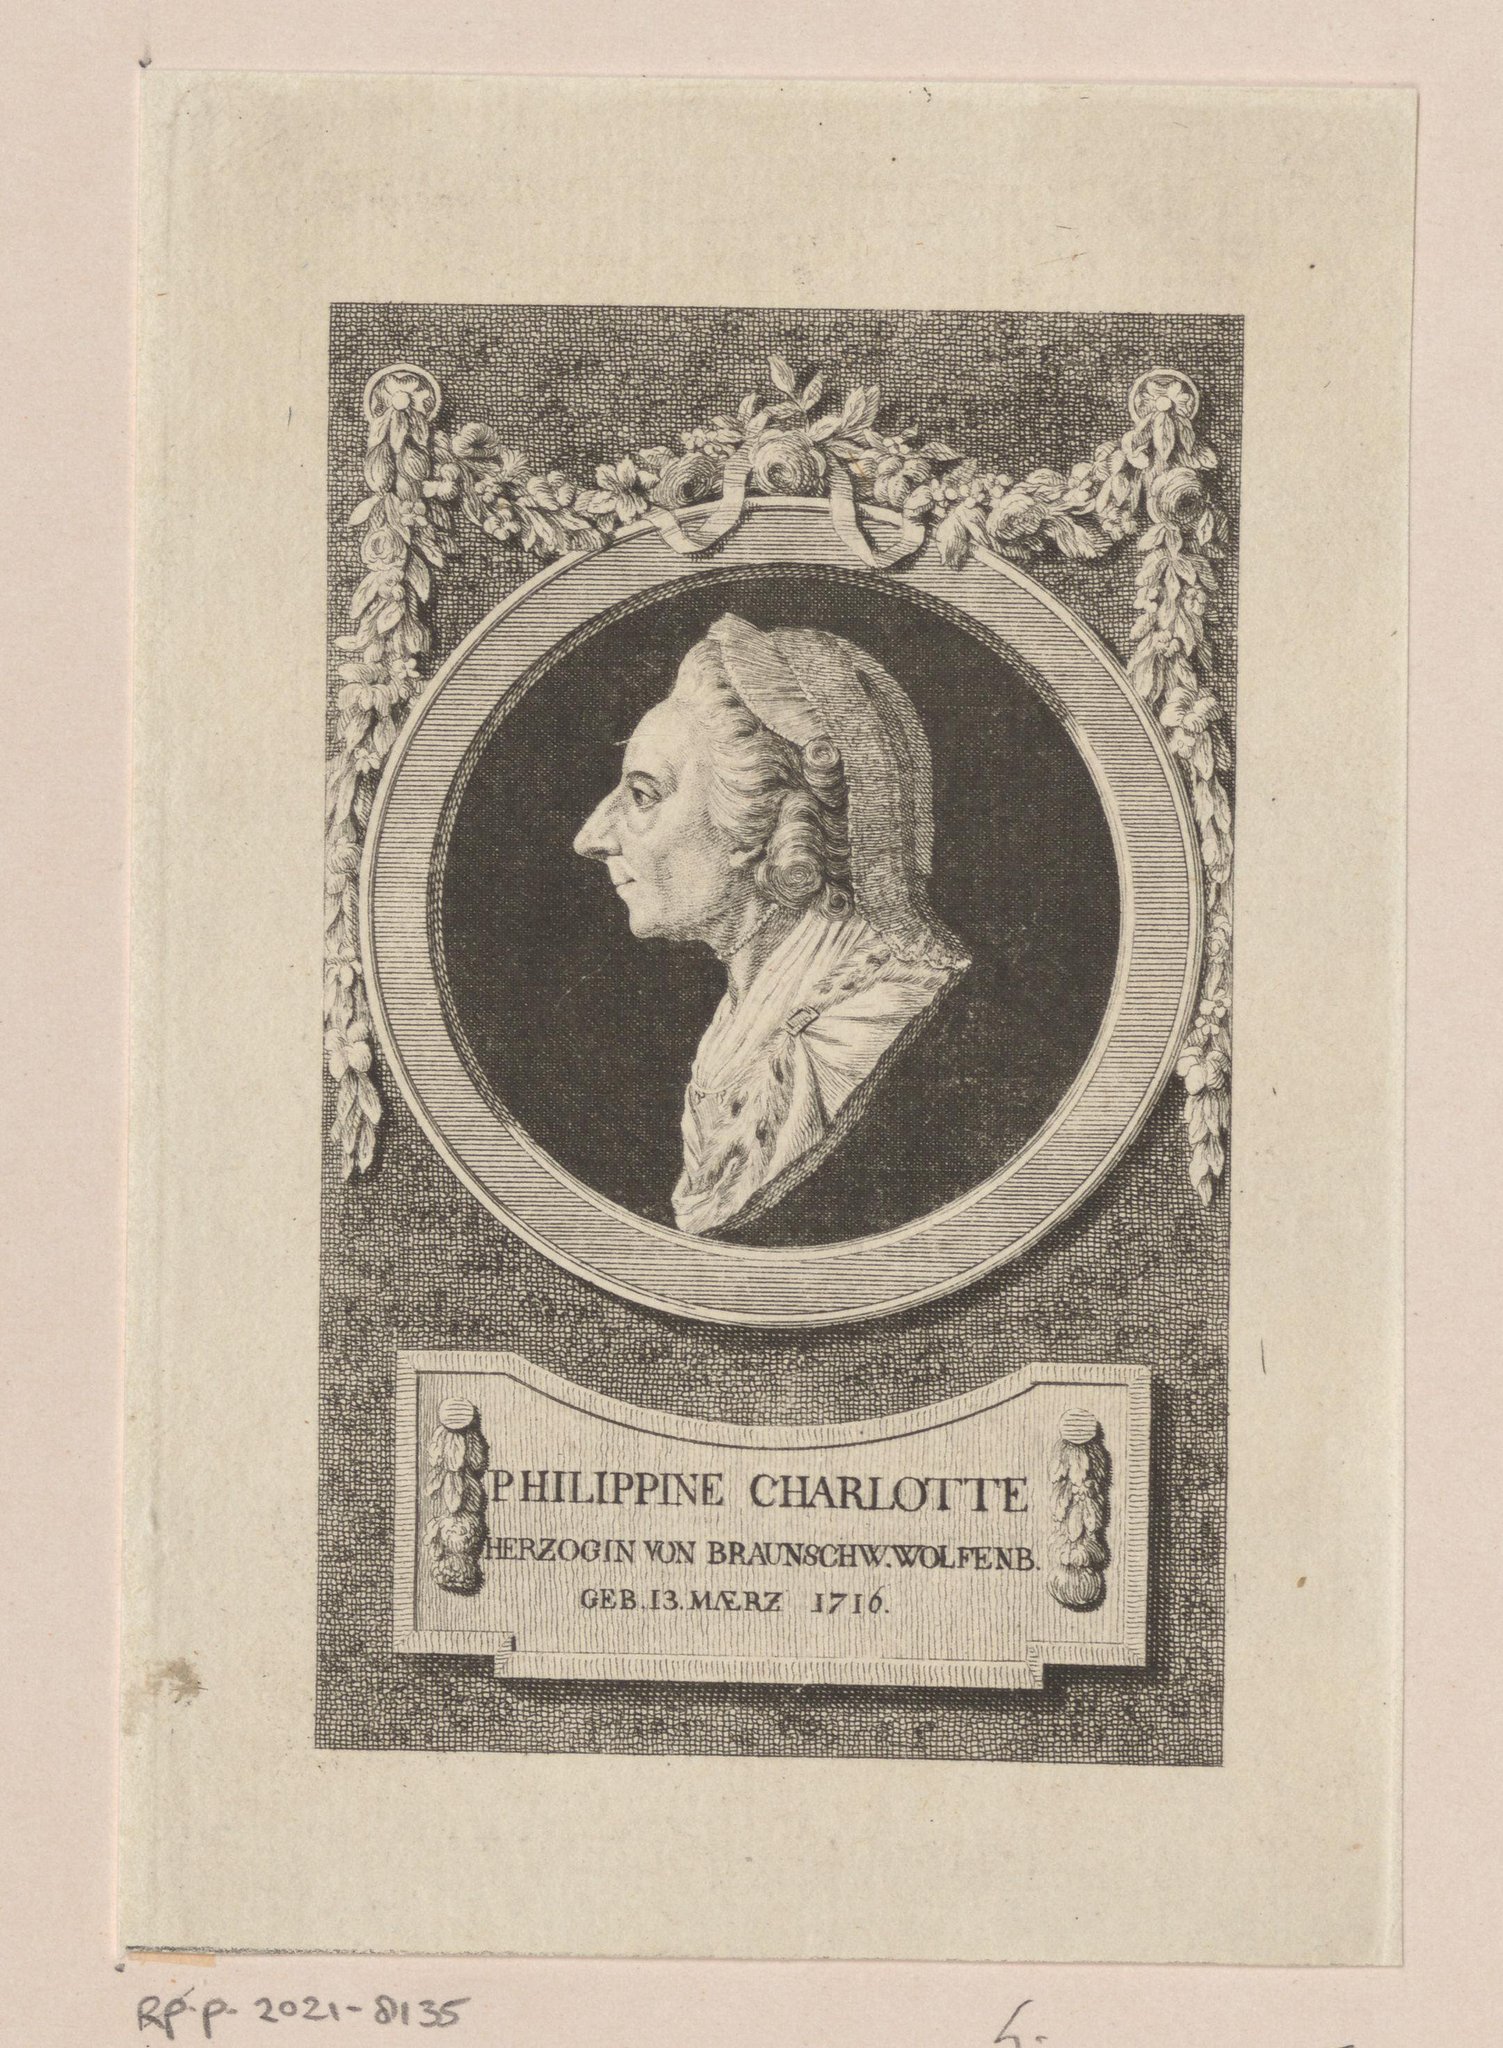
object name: print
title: Portret van Philippine Charlotte von Braunschweig-Lüneburg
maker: Anonymous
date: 1780-1824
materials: paper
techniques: engraving, etching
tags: berlin, historical persons, old woman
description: Philippine Charlotte is afgebeeld als weduwe.